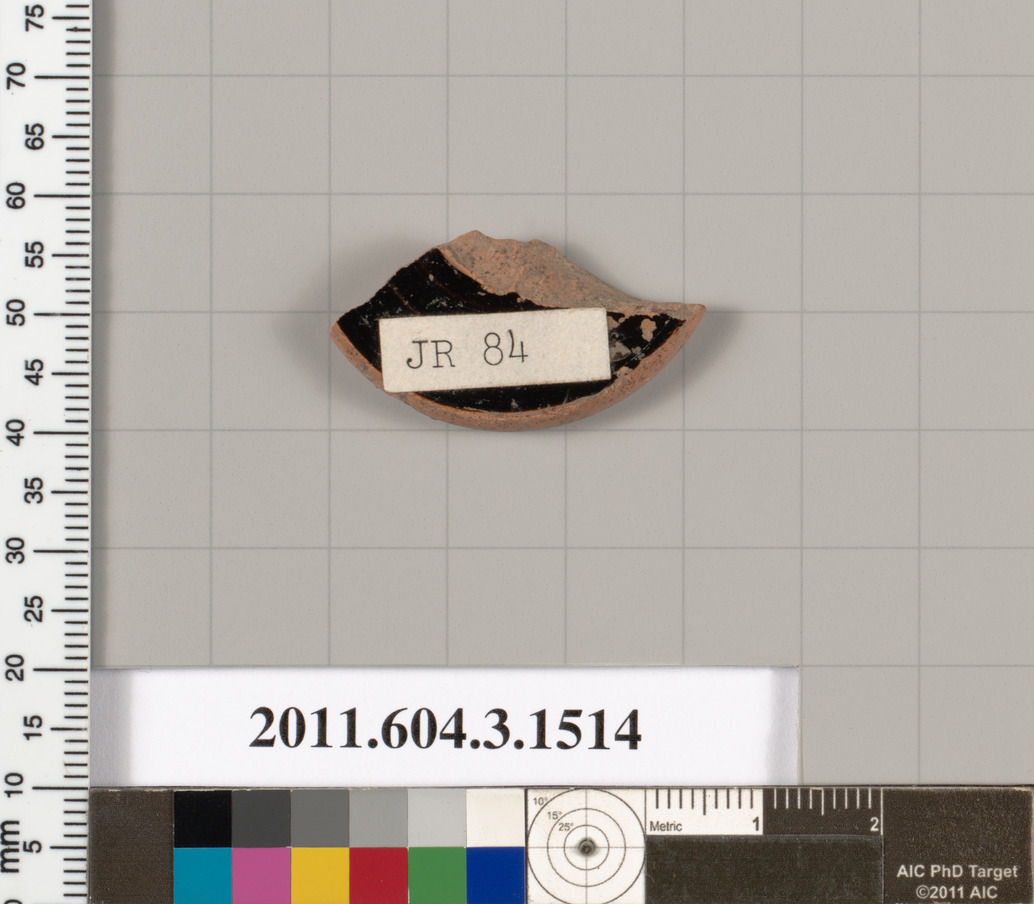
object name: lekythos fragment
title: Terracotta fragment of a lekythos (oil flask)?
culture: greek, attic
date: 600-401 BCE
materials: terracotta